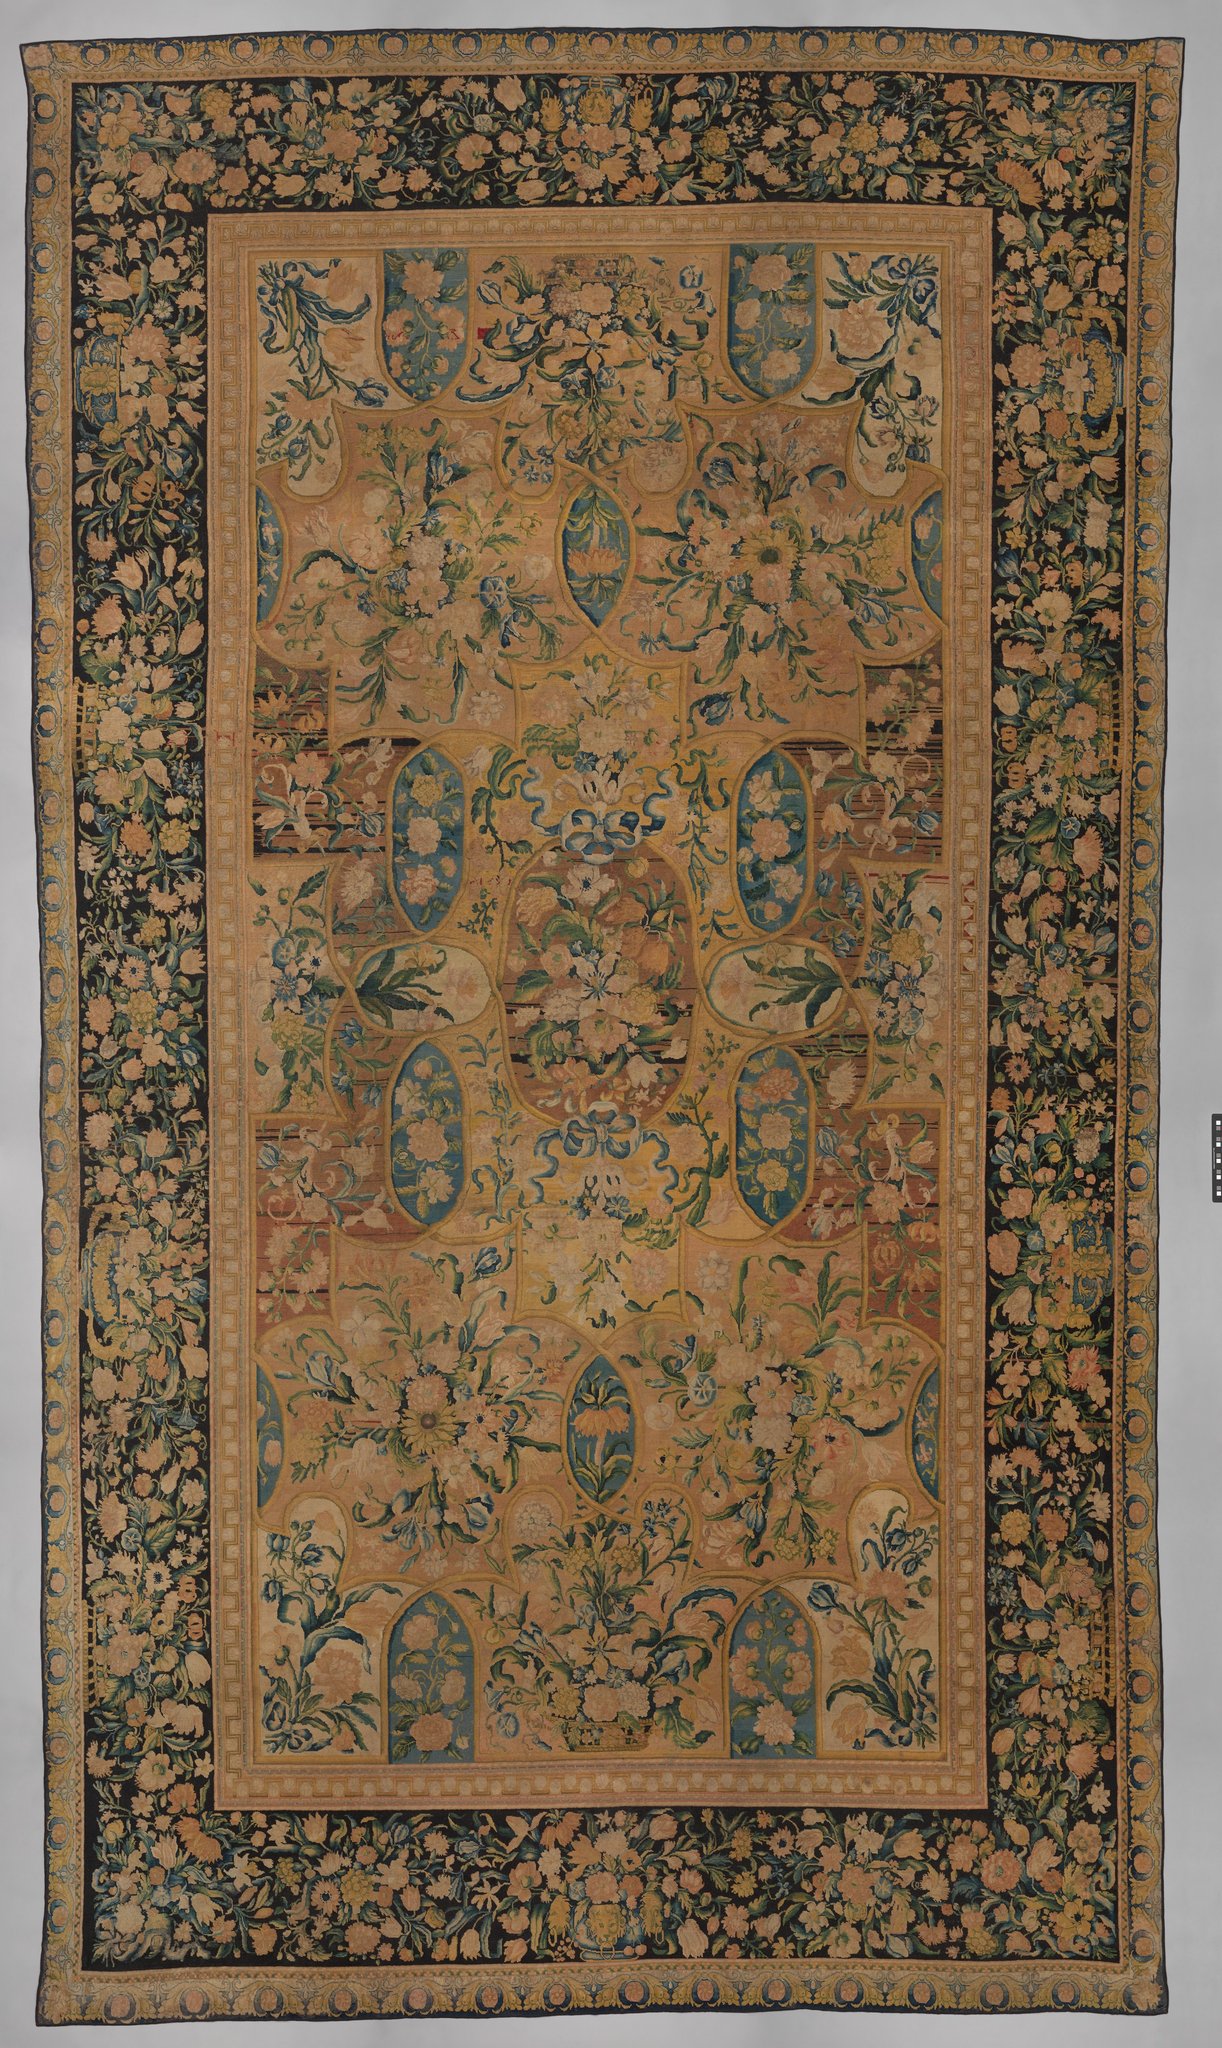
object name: carpet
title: Carpet (tapis)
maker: savonnerie manufactory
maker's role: manufactory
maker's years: 1626-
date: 1651-1675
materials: wool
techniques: cutting, weave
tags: flowers